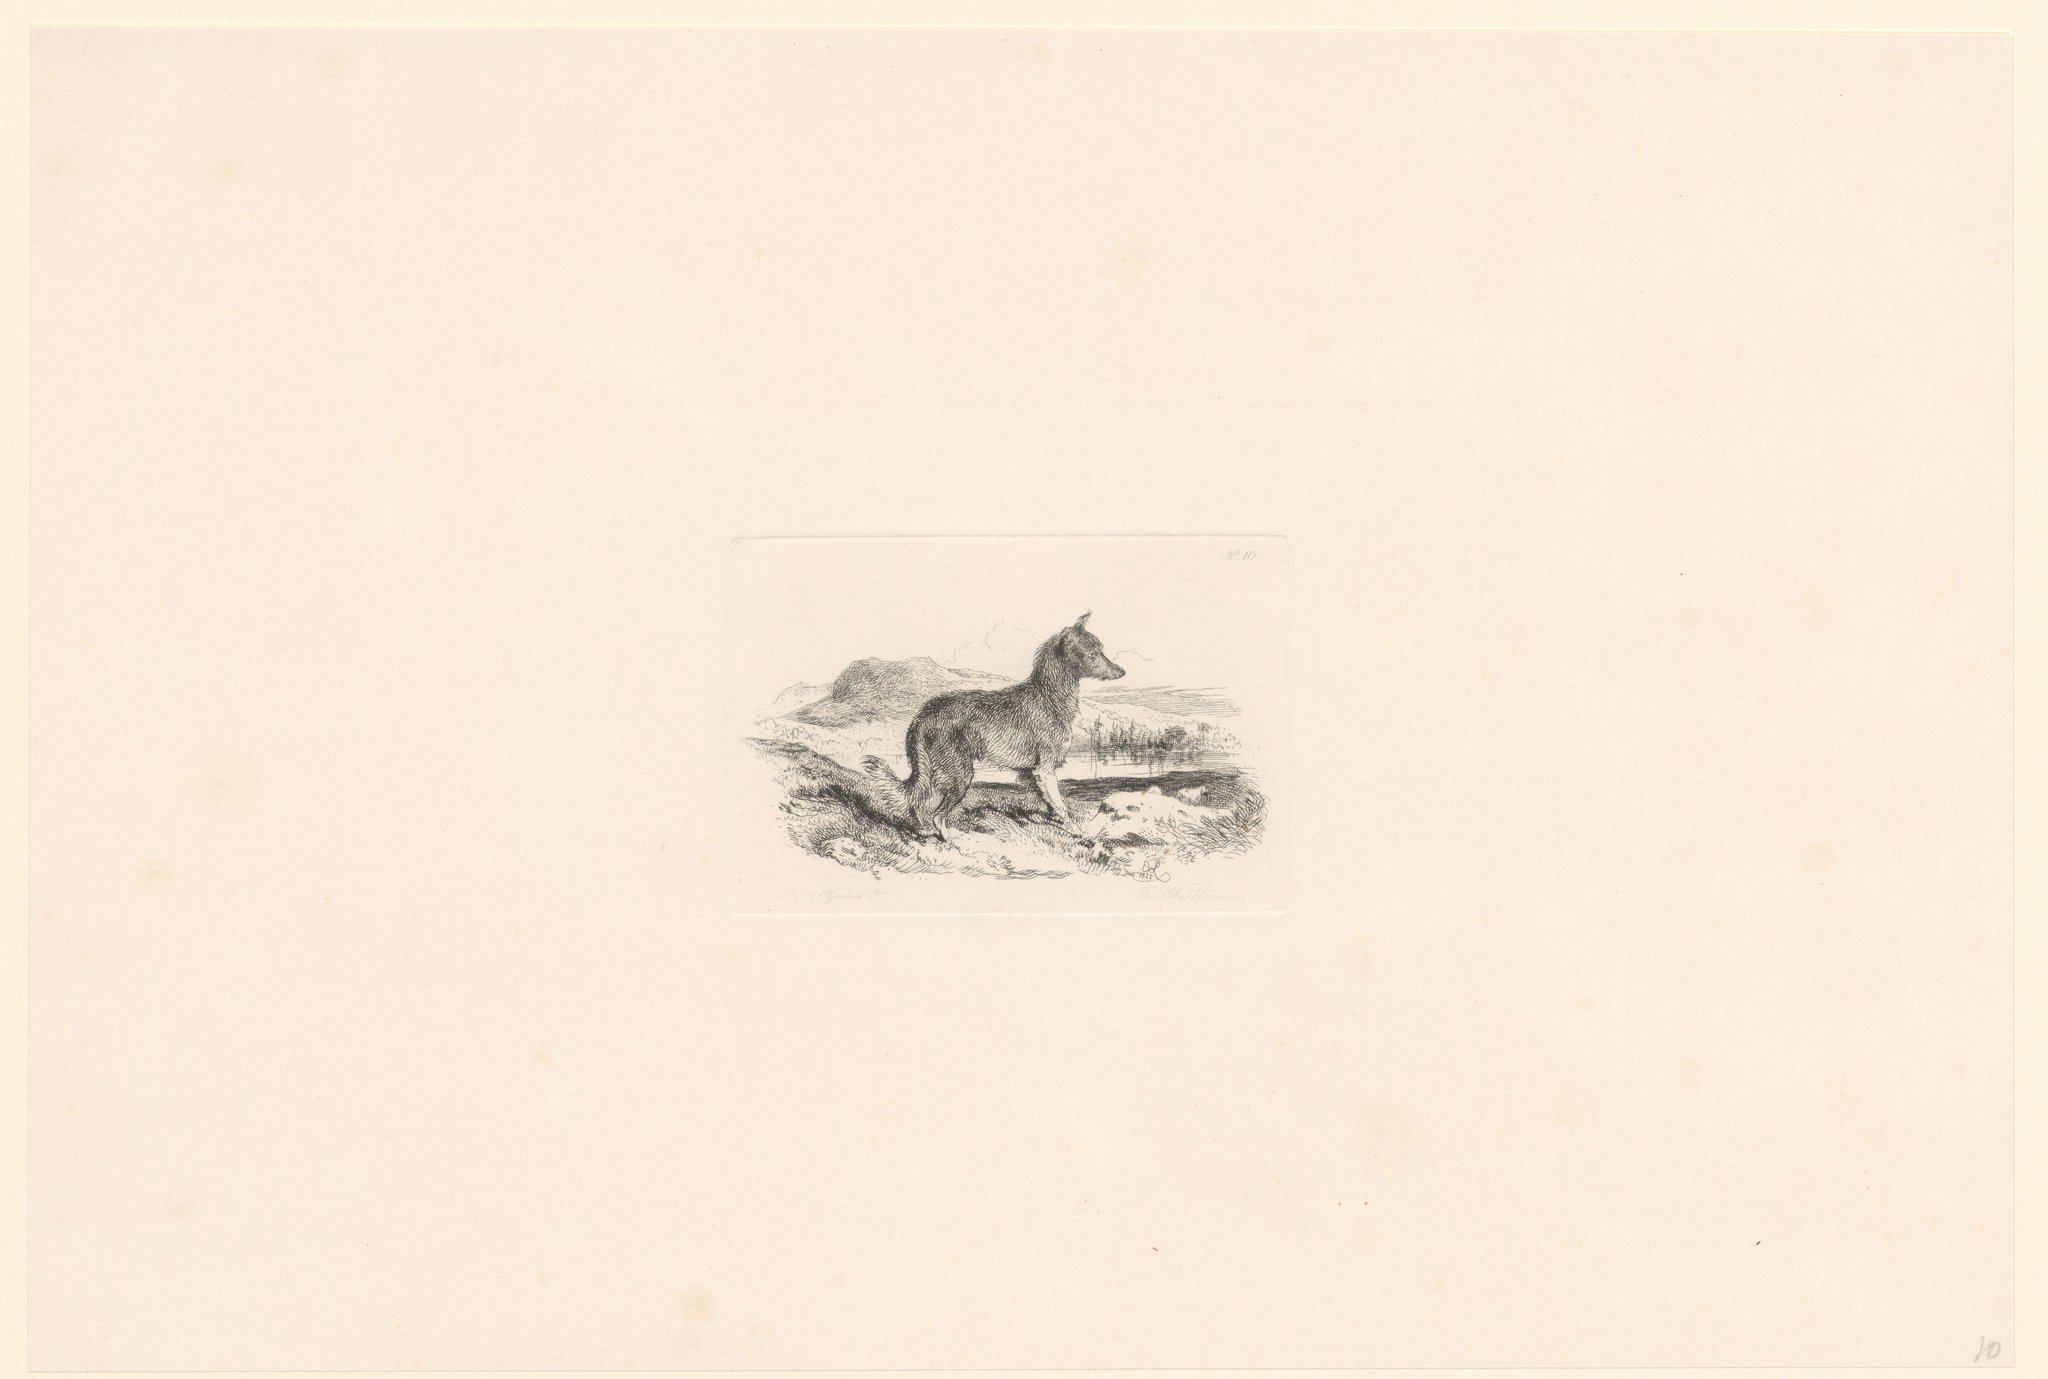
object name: print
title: Landschap met waakhond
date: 1825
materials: paper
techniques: etching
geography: london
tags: watch-dog, dog watching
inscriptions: collector's mark: Lugt 2228, check stamp: Lugt 4736